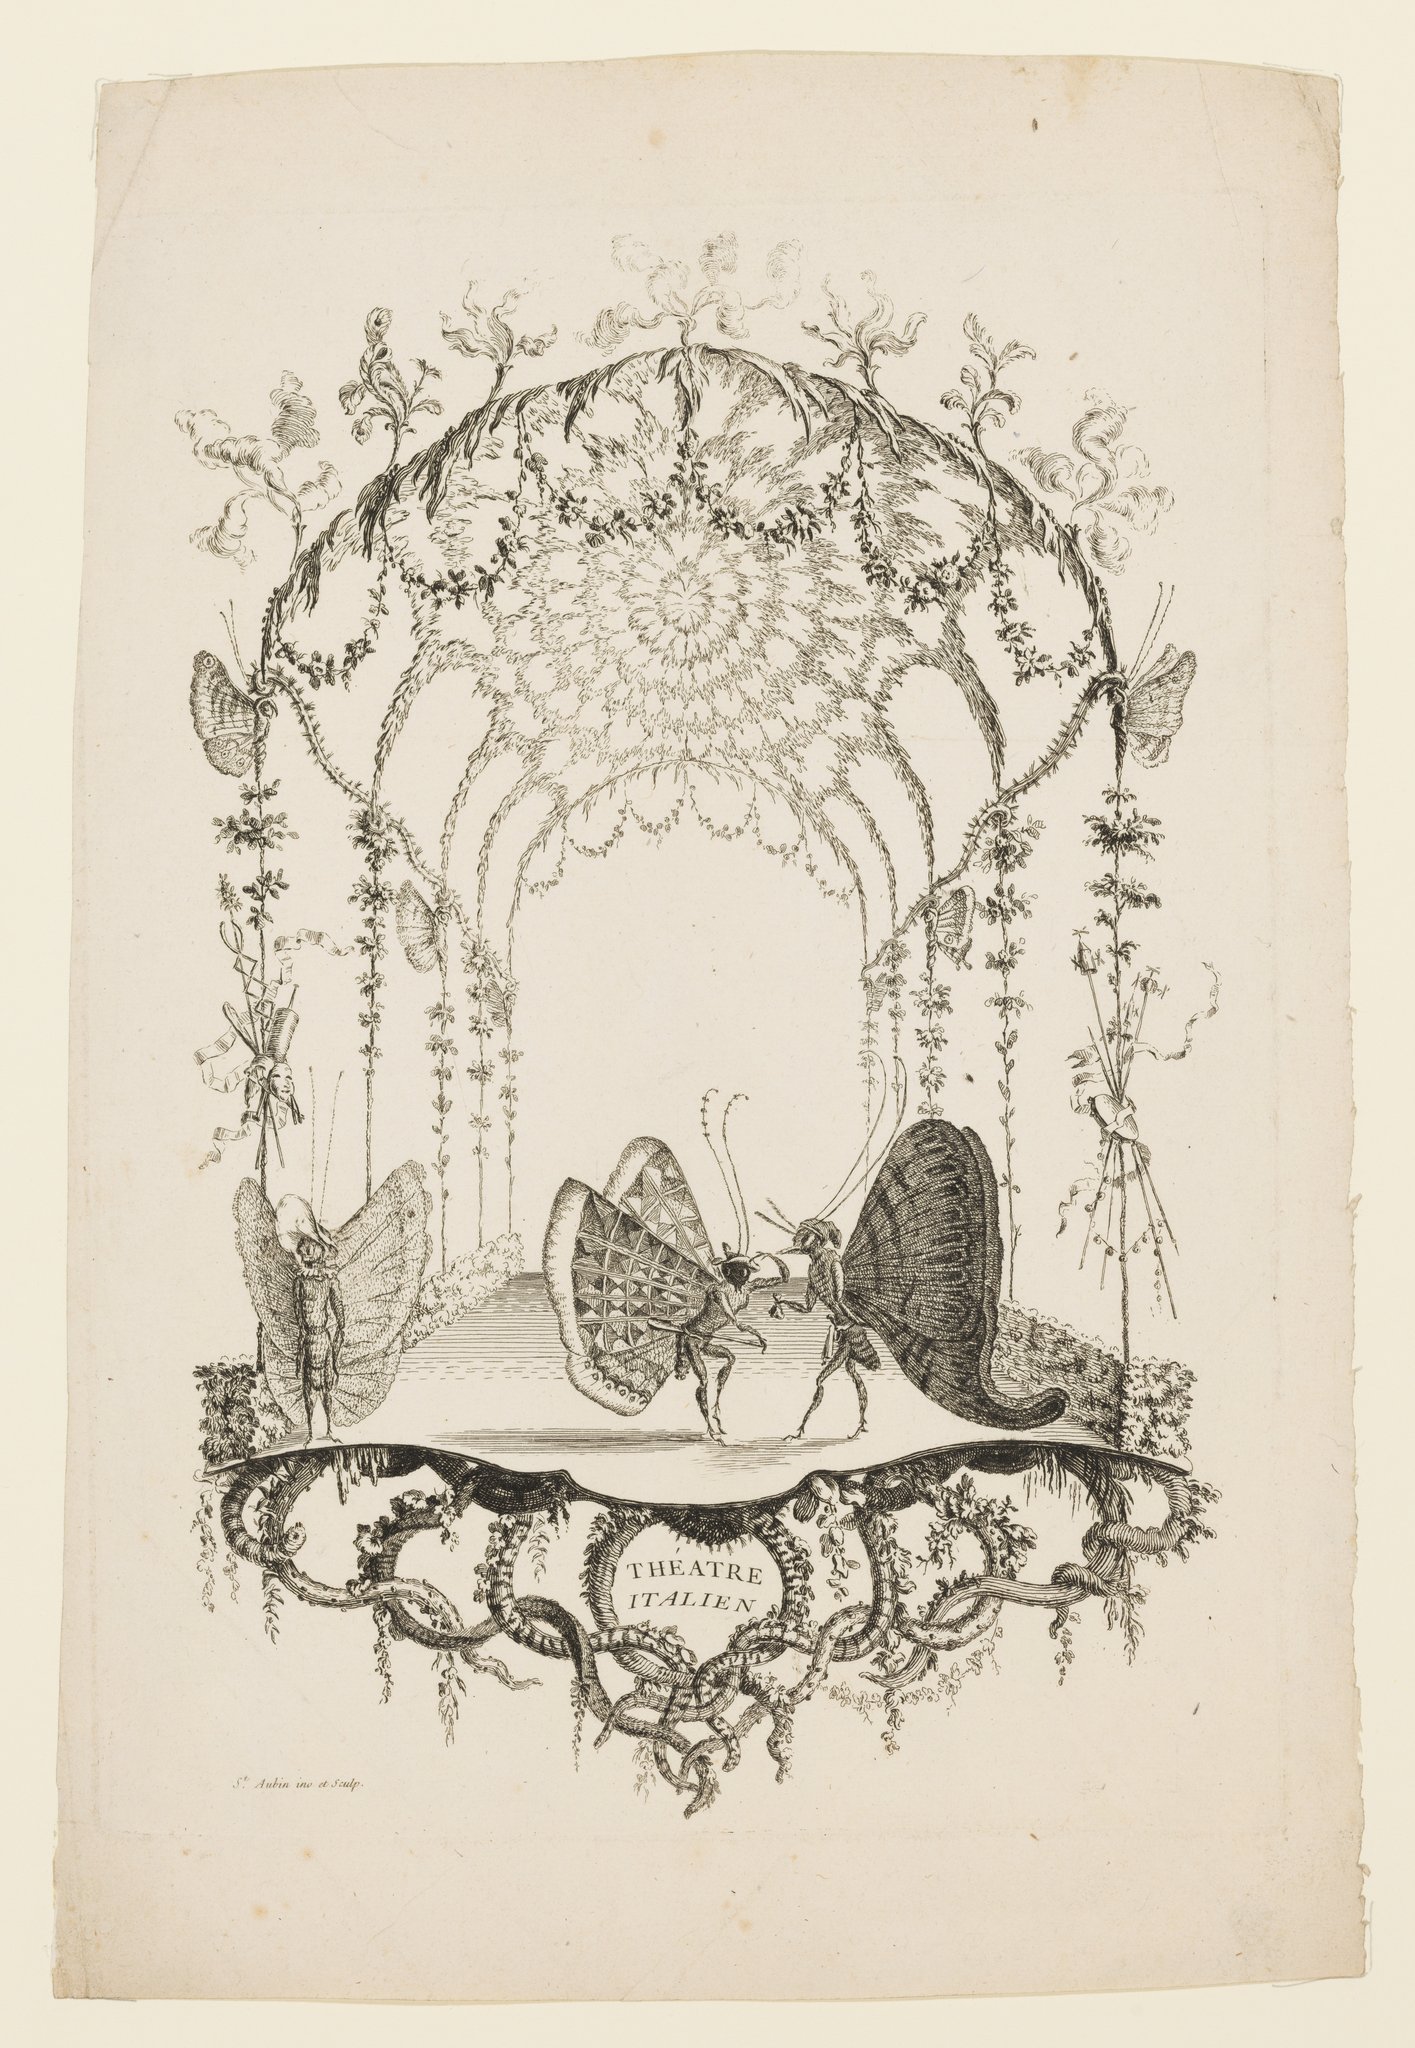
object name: print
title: Italian Theatre (Théatre Italien), from Essai de Papilloneries Humaines par Saint Aubin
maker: charles germain de saint-aubin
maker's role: artist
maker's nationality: french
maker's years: 1721-1786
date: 1756-1760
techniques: etching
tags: theatre,butterflies